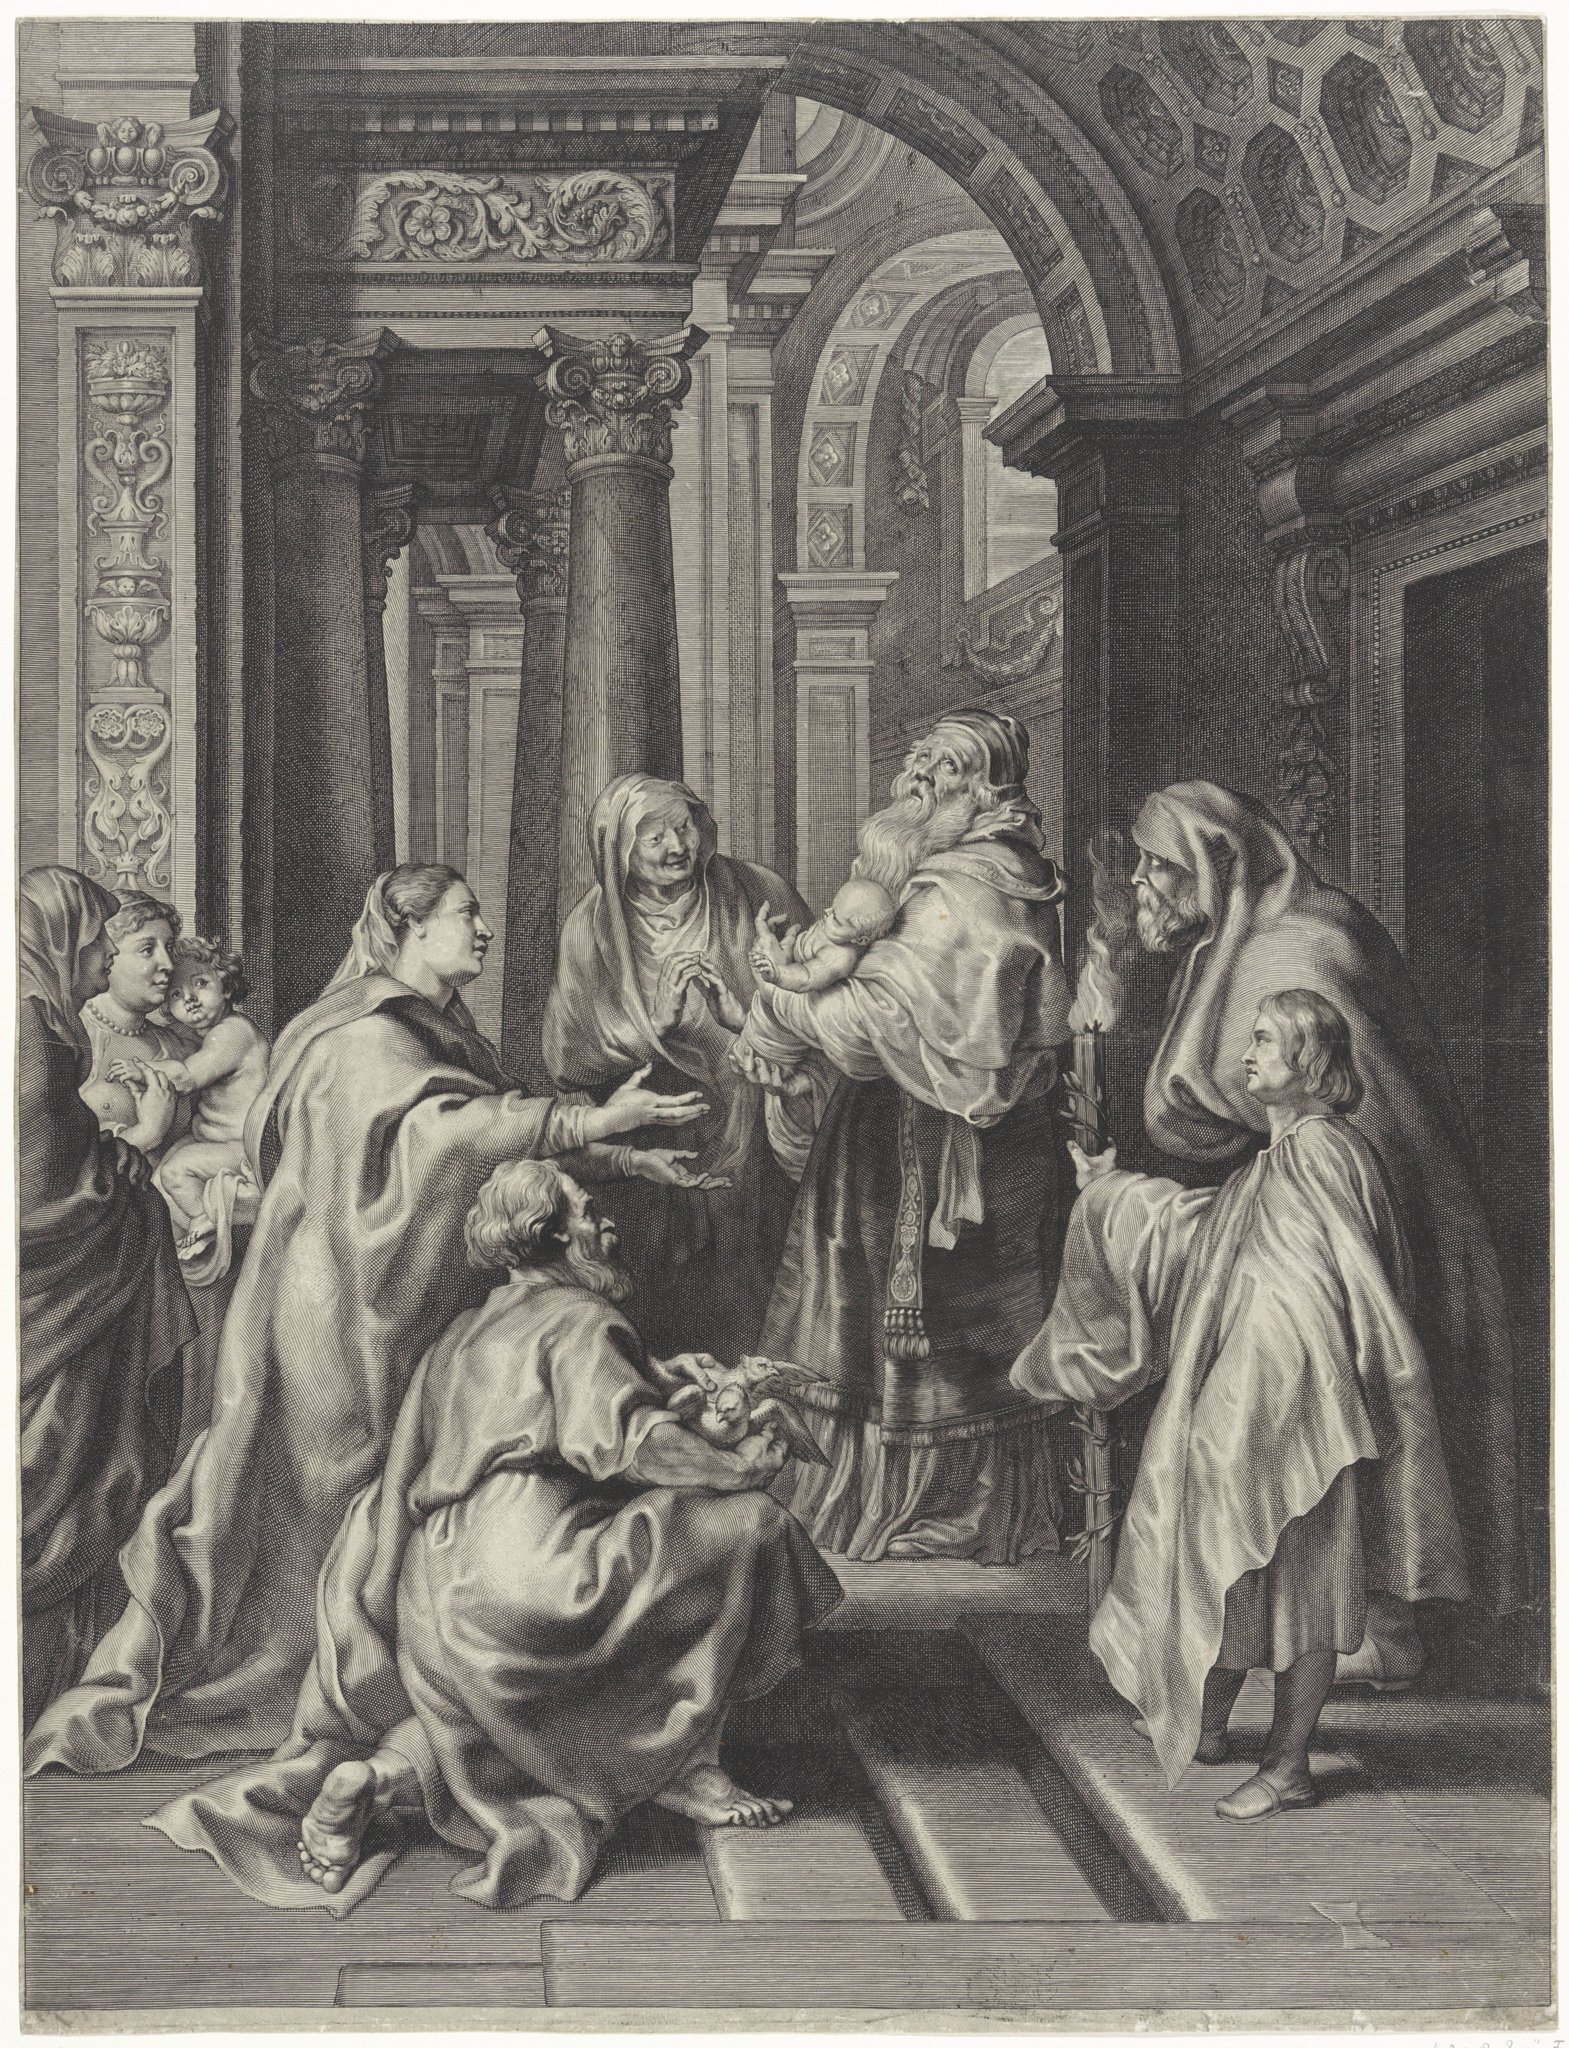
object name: print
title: Presentatie in de tempel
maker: paulus pontius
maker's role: draughtsman, print maker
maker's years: 1603-1658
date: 1638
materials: paper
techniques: engraving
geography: antwerp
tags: presentation of the christ-child in the temple, usually simeon (and anna) present (luke 2:22-39)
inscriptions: collector's mark: Lugt 240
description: Maria en Jozef hebben Christus naar de tempel gebracht. De hogepriester Simeon houdt het Kind in zijn armen. Jozef knielt voor hen en houdt een paar duiven vast. De profetes Hanna kijkt in aanbidding toe.